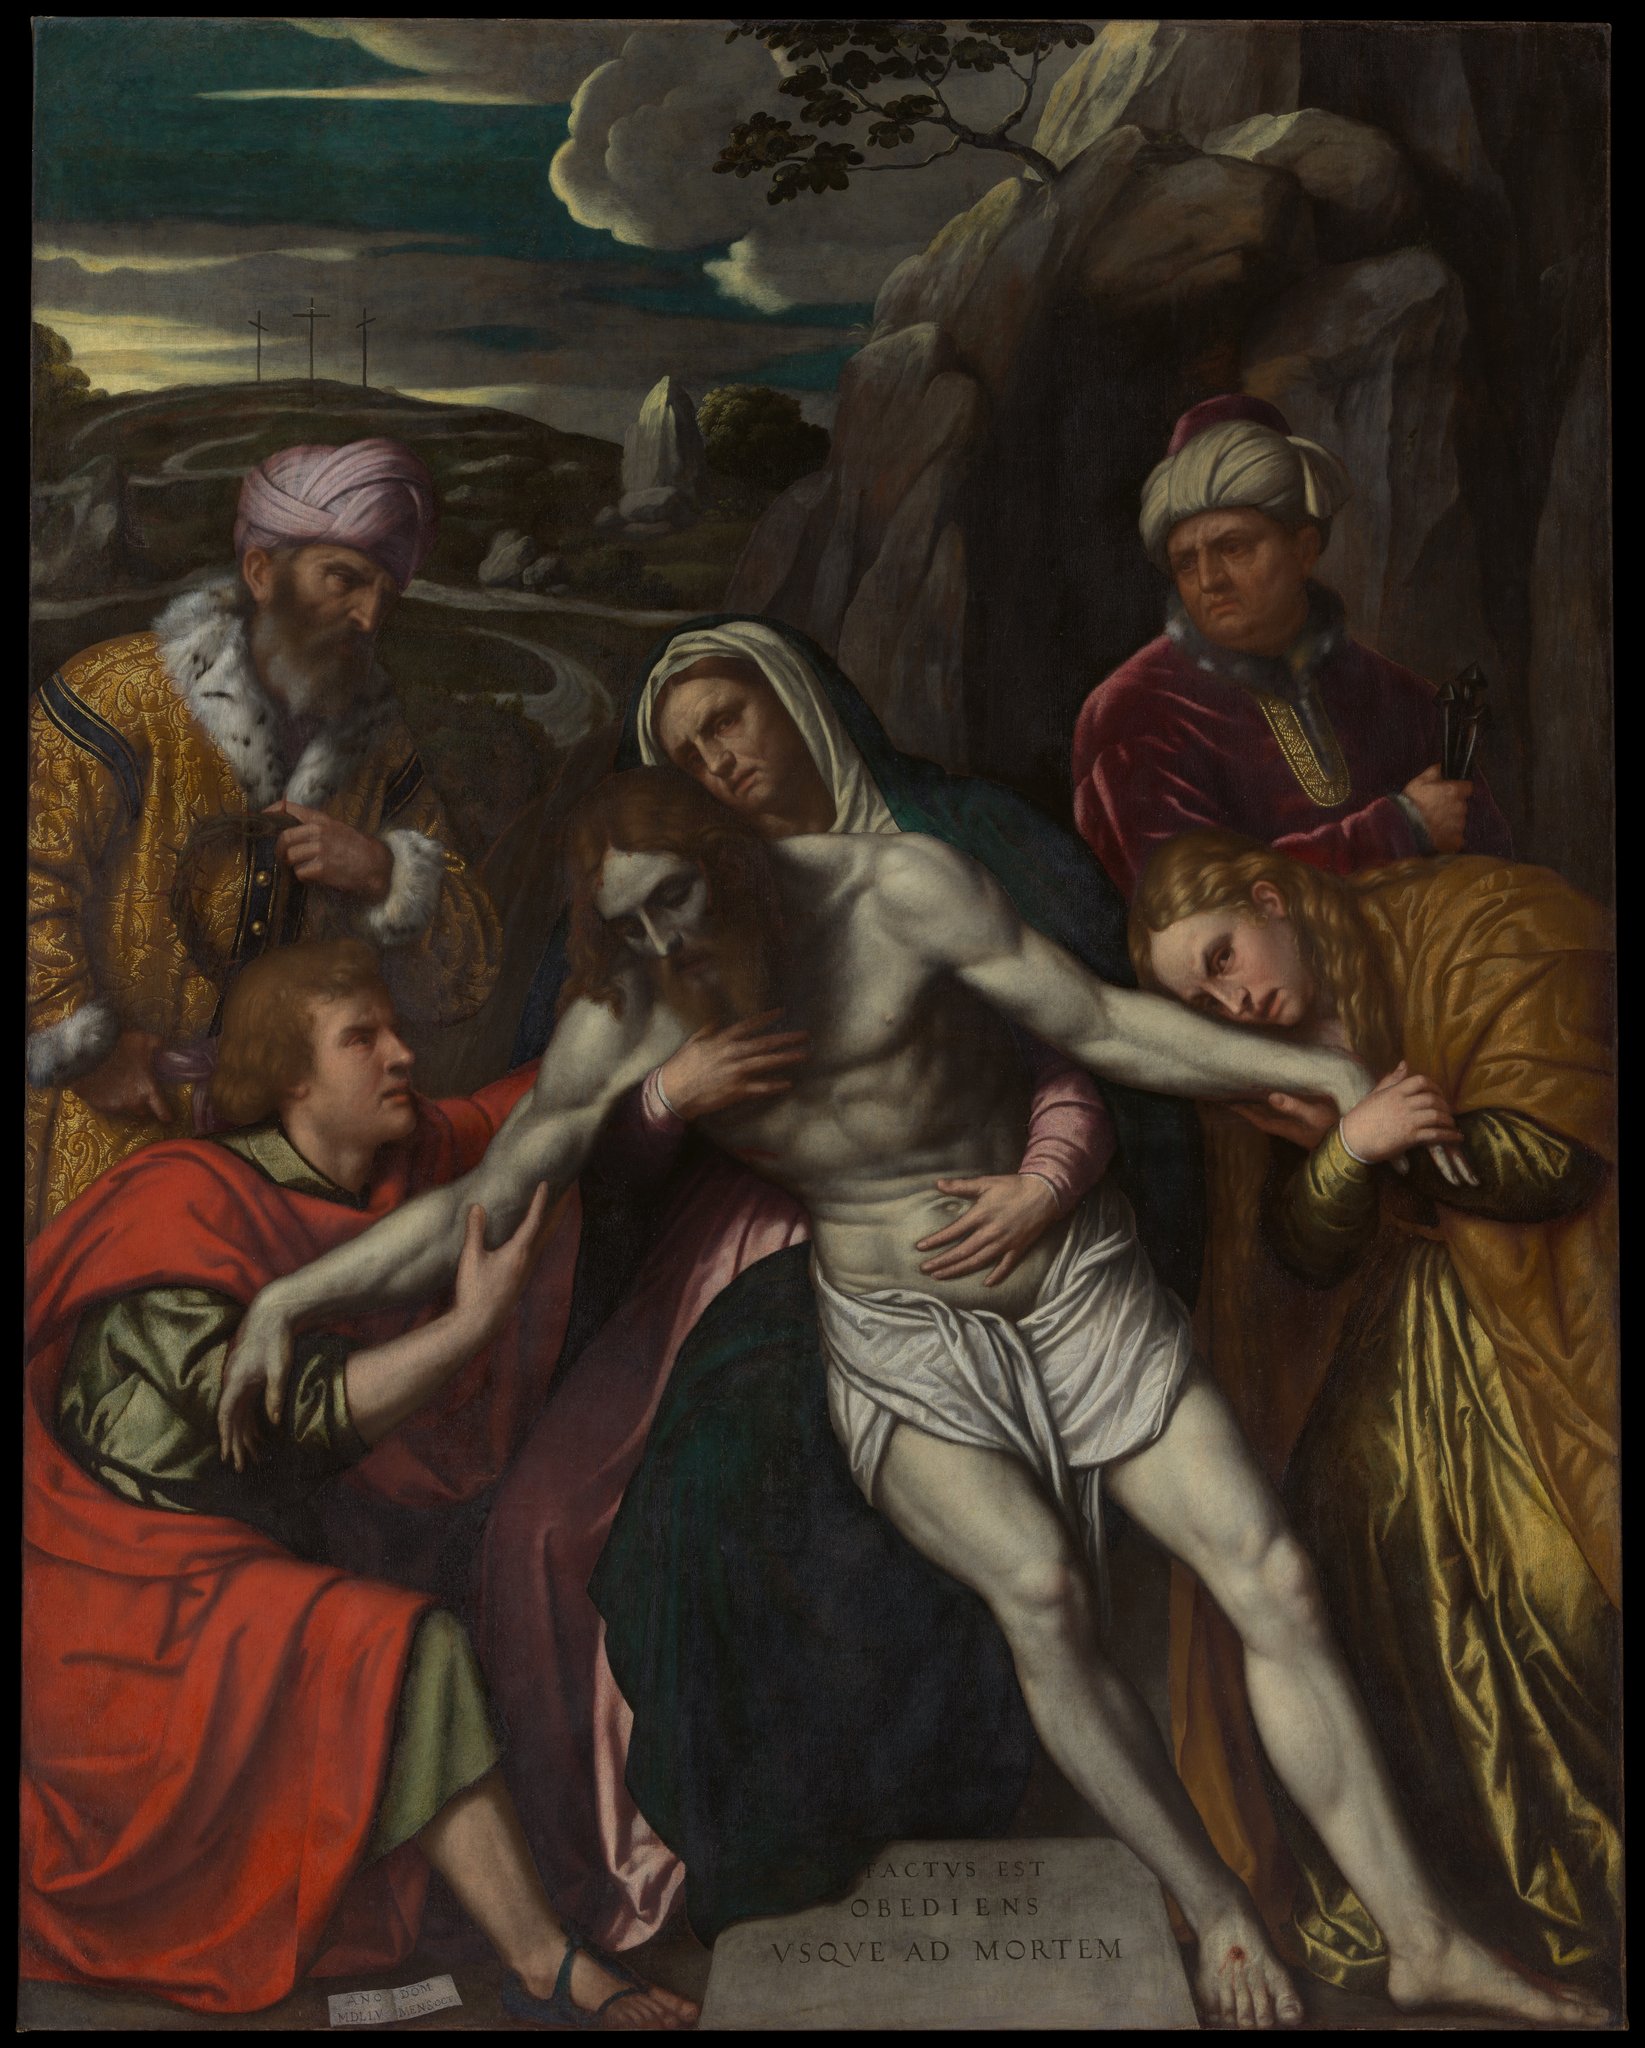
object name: painting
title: The Entombment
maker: moretto da brescia (alessandro bonvicino)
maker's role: artist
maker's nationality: italian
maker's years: 1498-1554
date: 1554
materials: canvas, oil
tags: sadness,christ,mary magdalene,virgin mary,entombment